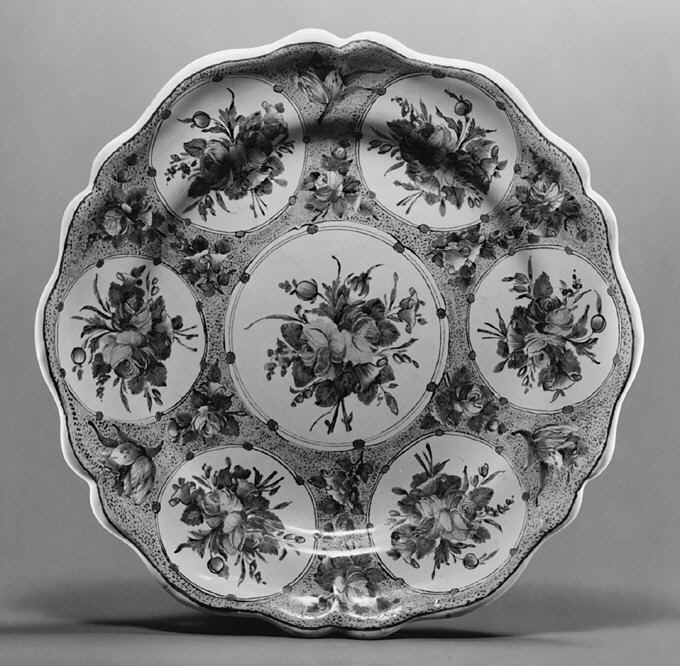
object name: plate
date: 1775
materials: faience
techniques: glazing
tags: flowers